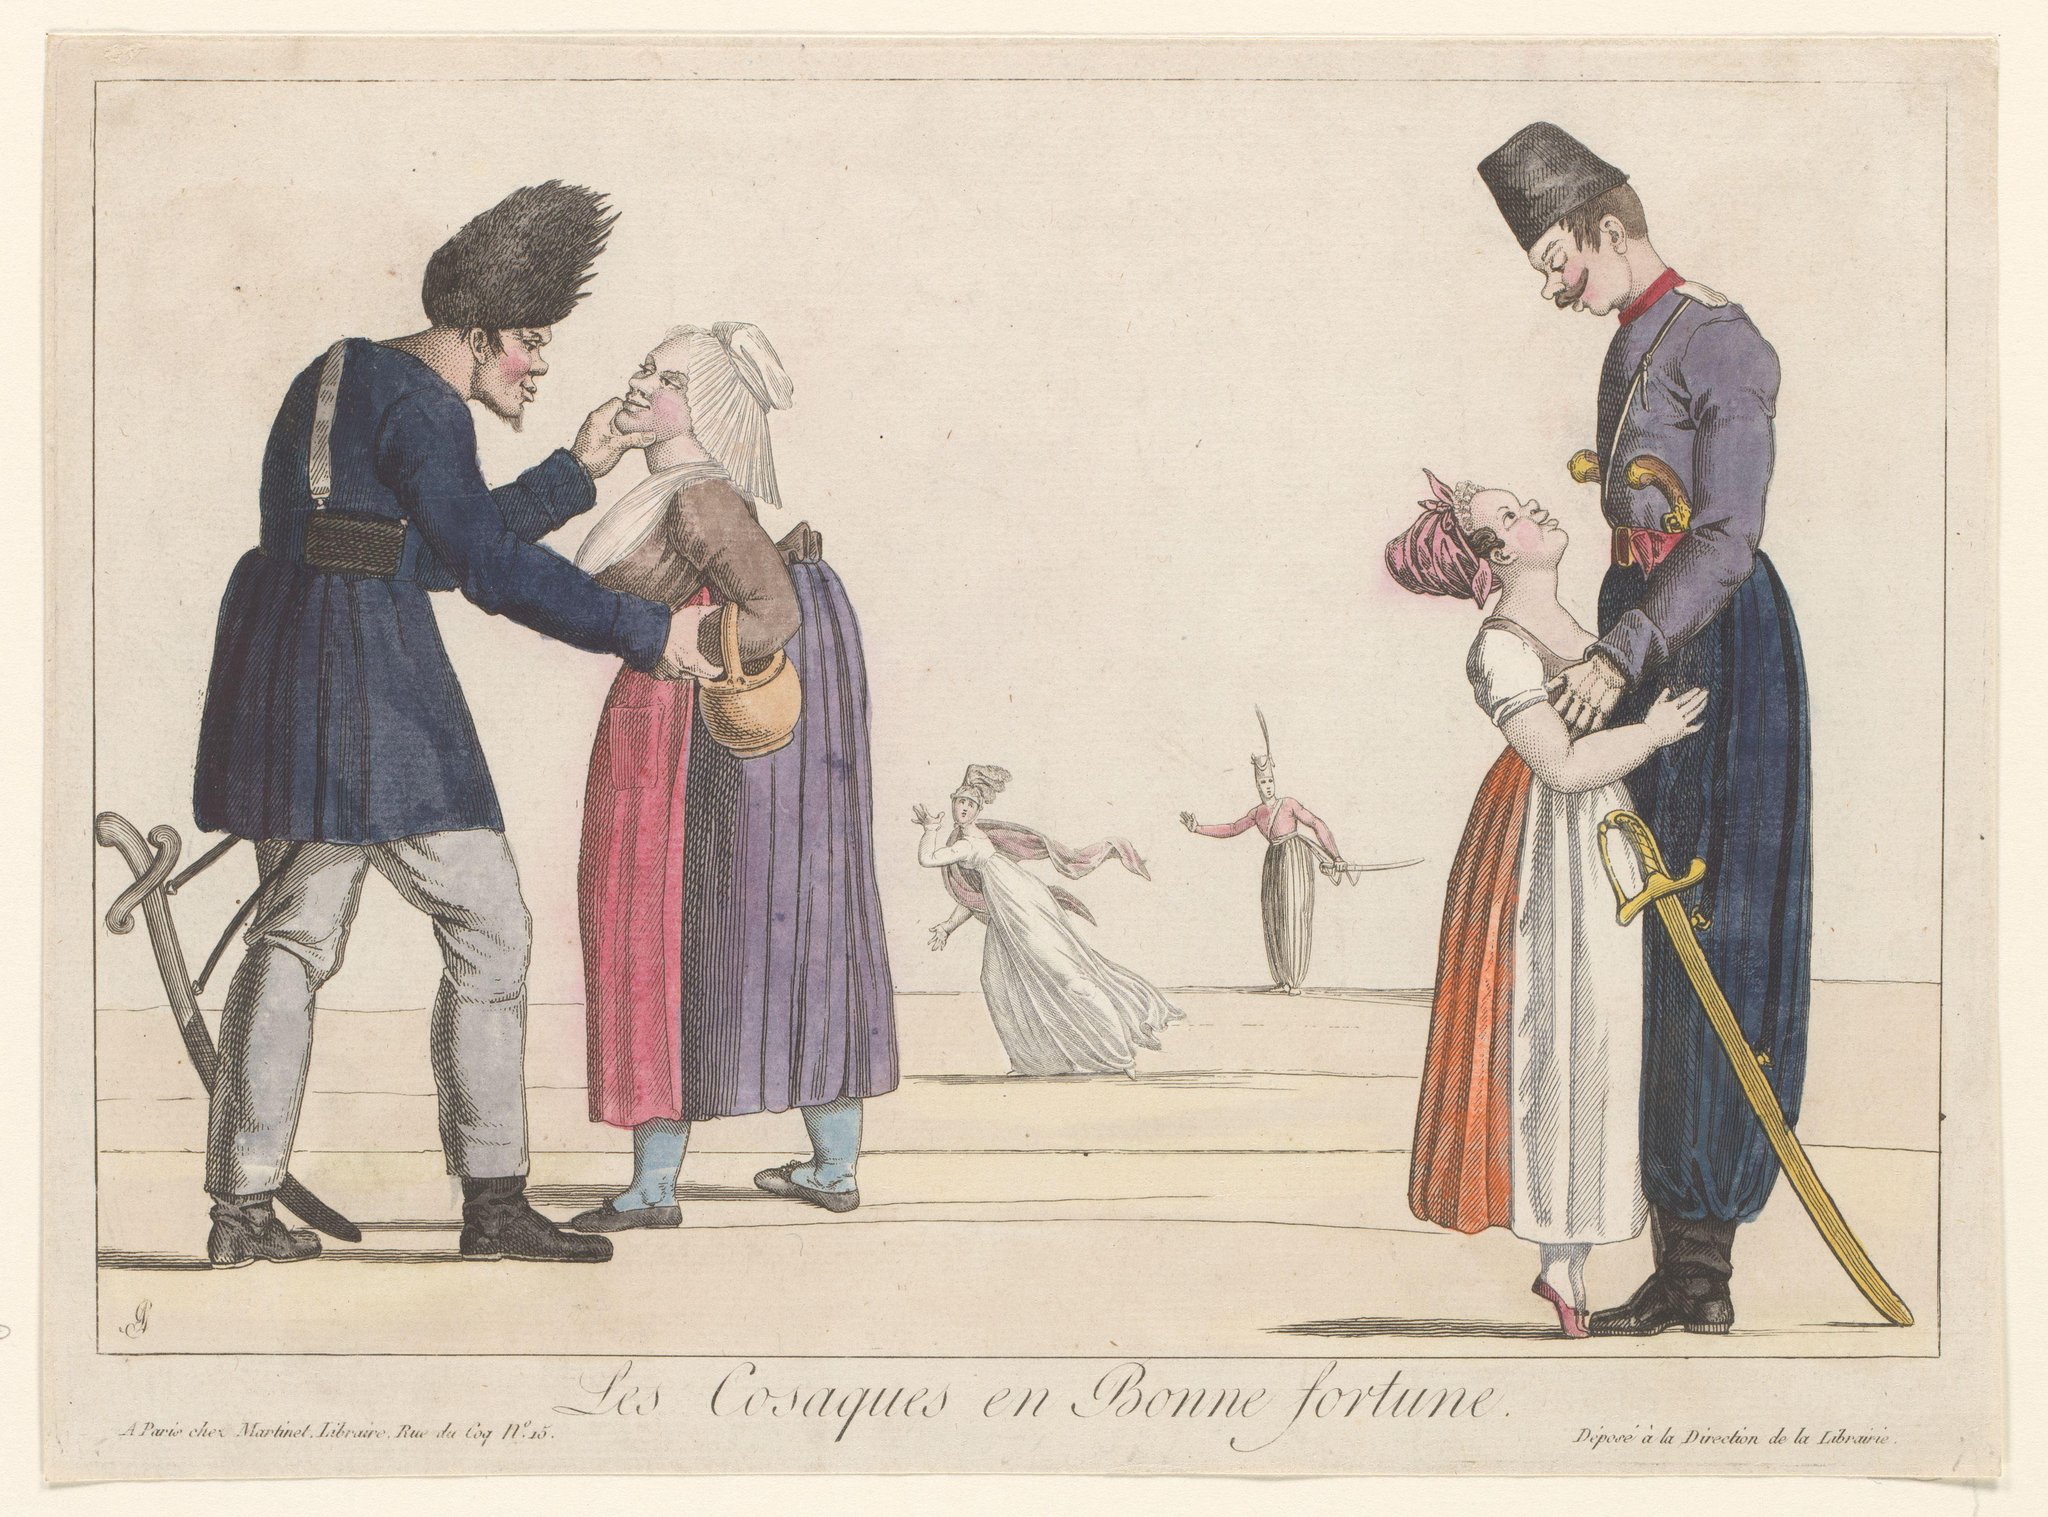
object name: cartoon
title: Les Cosaques en Bonne Fortune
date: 1814-1815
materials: paper, watercolor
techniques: engraving, etching, hand coloring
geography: france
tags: soldiers and civilians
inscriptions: collector's mark: Lugt 2228